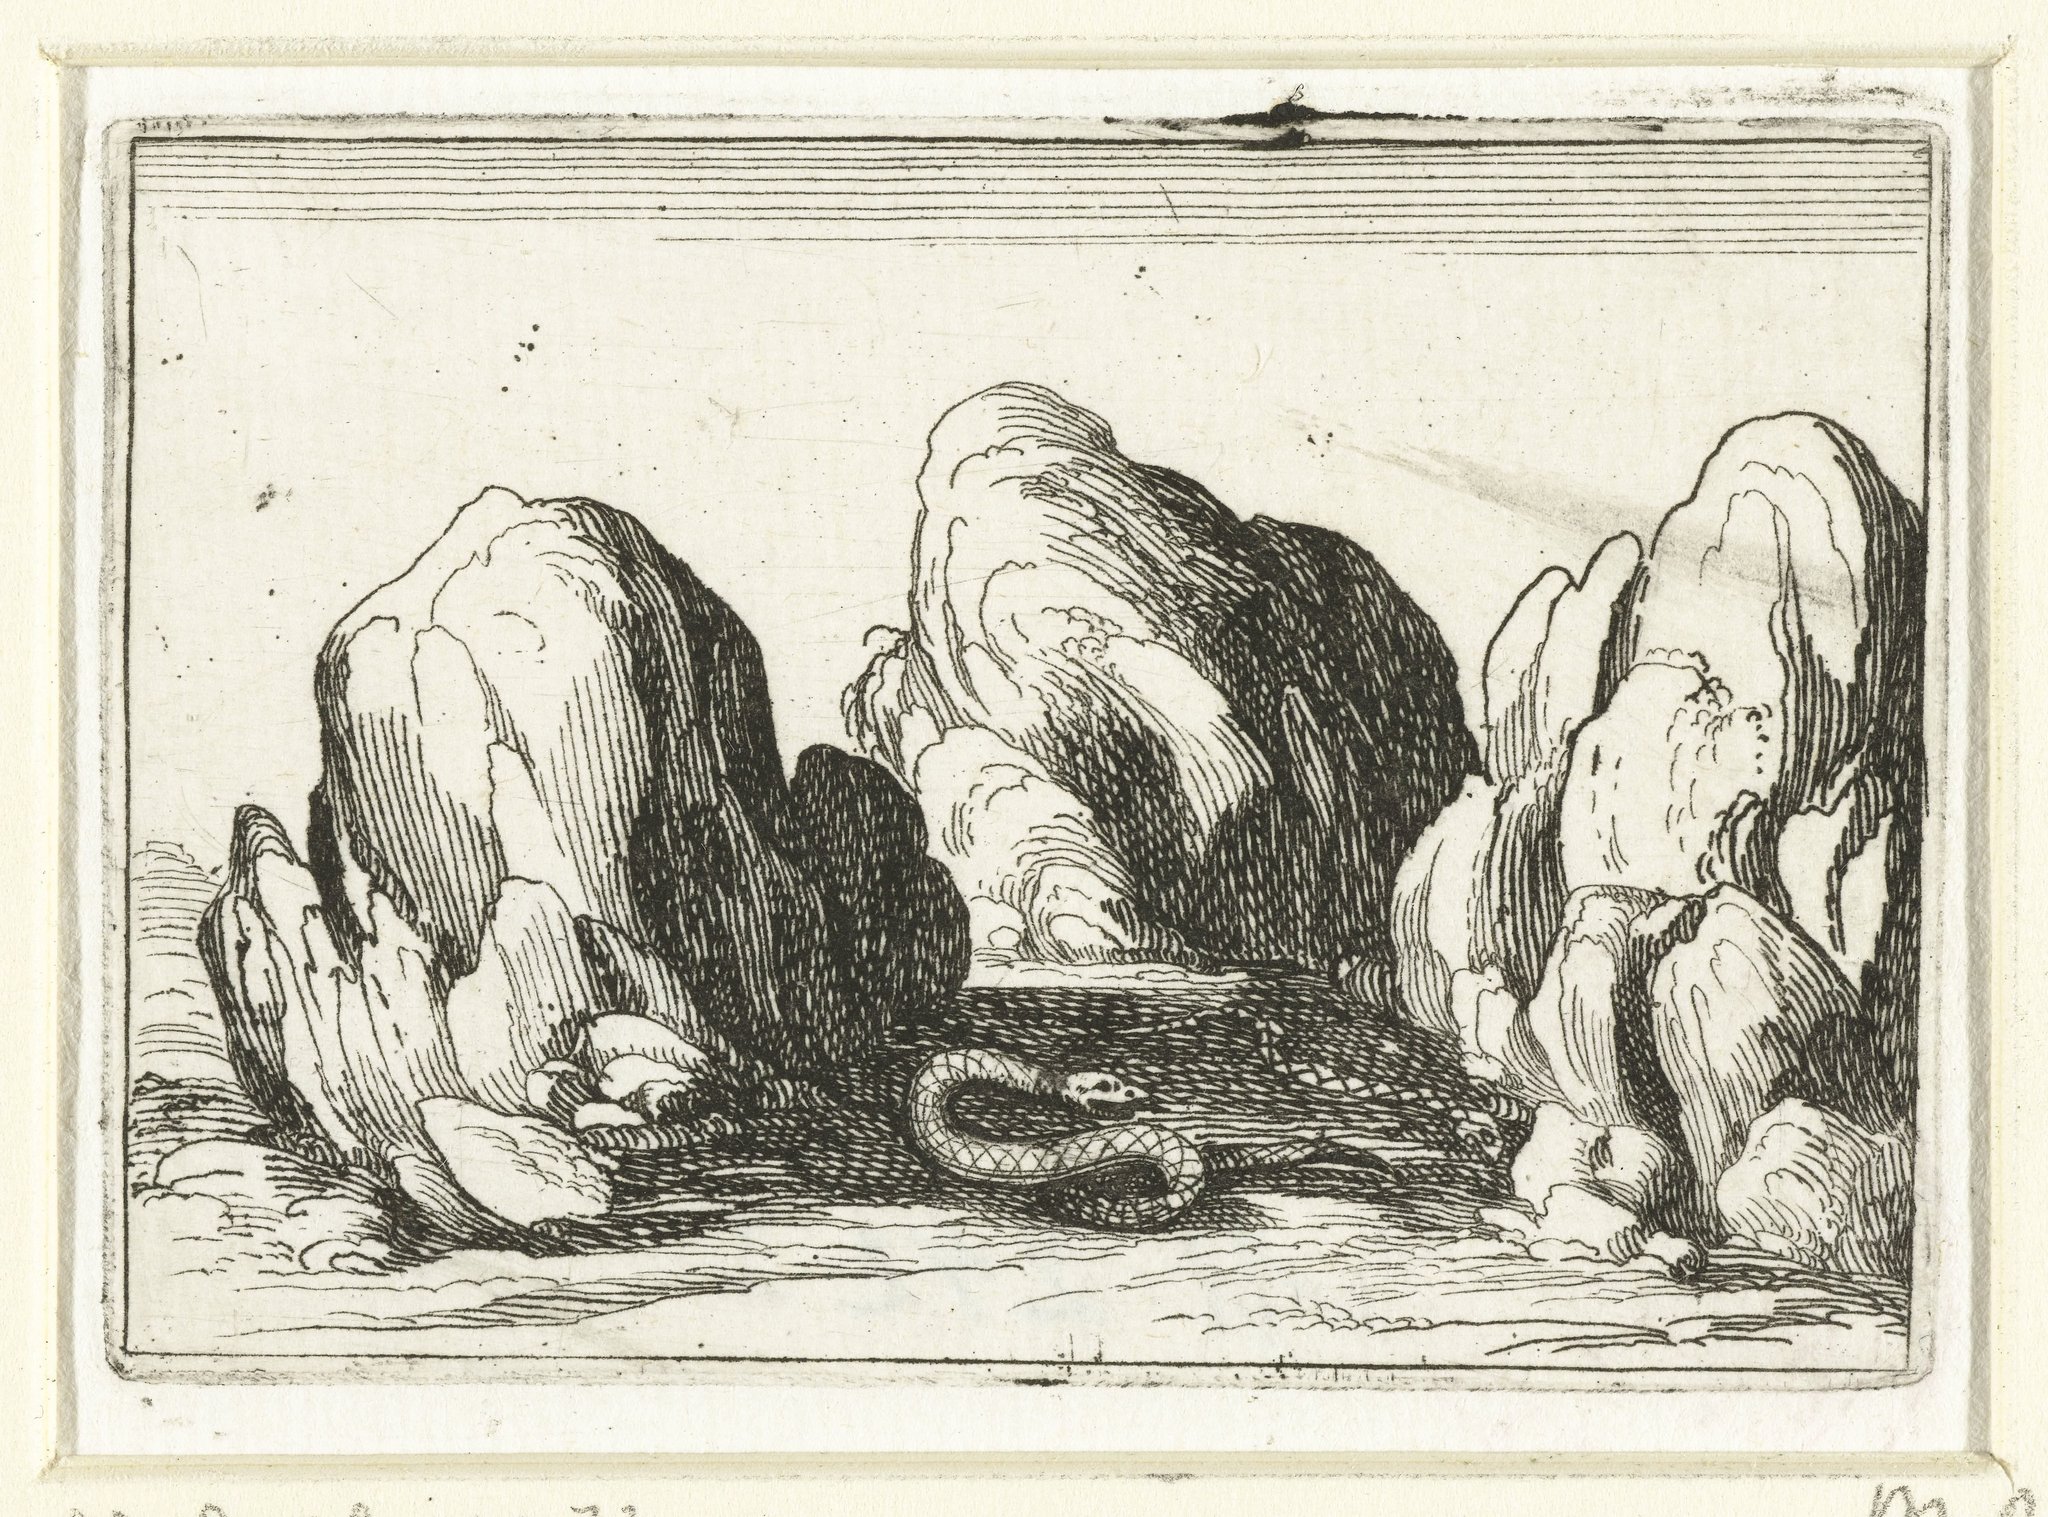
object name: cognizance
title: Vervellende slang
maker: jacques callot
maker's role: draughtsman, print maker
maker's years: 1592-1635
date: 1621-1635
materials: paper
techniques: etching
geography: nancy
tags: snakes, animals (+ shedding of skin of animal(s))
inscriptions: collector's mark: Lugt 240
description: Voorstelling van een slang tussen de rotsen; het oude vel waarvan hij zich zojuist ontdaan heeft ligt rechts naast hem. Dit blad is onderdeel van de embleemserie 'Kloosterleven in emblemen'. De tweede staat van deze serie behelst naast een geïllustreerde titelpagina en 26 emblemen nog een titelpagina en een blad met opdracht, beide in boekdruk zonder afbeelding.